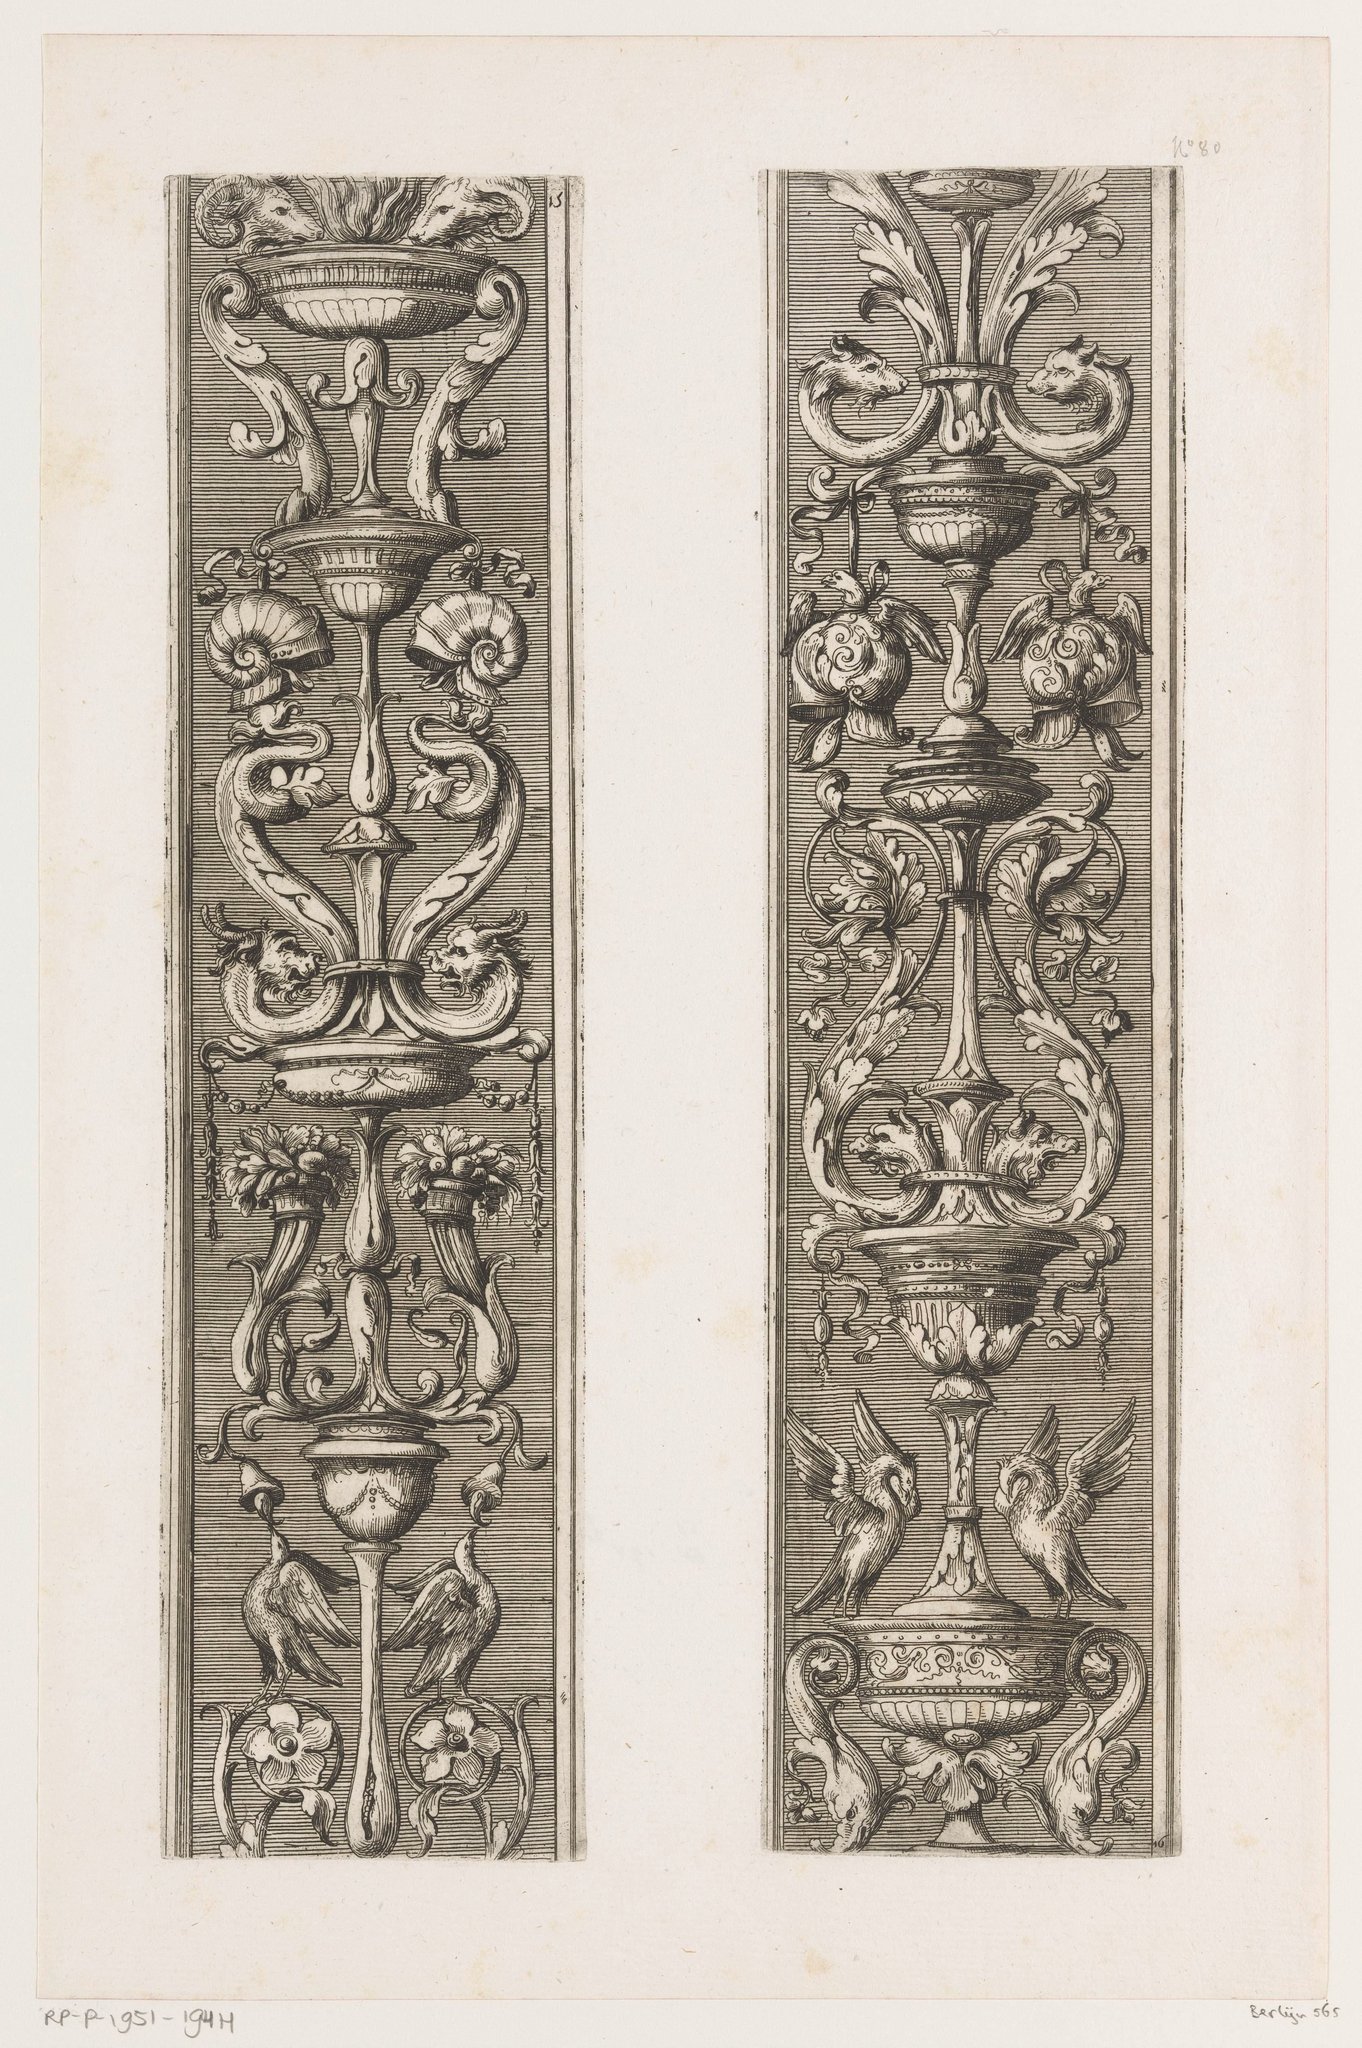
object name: print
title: Kandelabers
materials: paper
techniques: etching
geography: rome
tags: ornament ~ candelabrum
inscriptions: collector's mark: Lugt 2228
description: Deze prent maakt deel uit van een reeks van 48 prenten plus een titelprent. Mitelli maakte tekeningen van marmeren pilasterdecoraties van de poort van de S. Bartolomeo di Porta Ravegnana in Bologna. Deze prenten zijn vervolgens naar die tekeningen gemaakt.